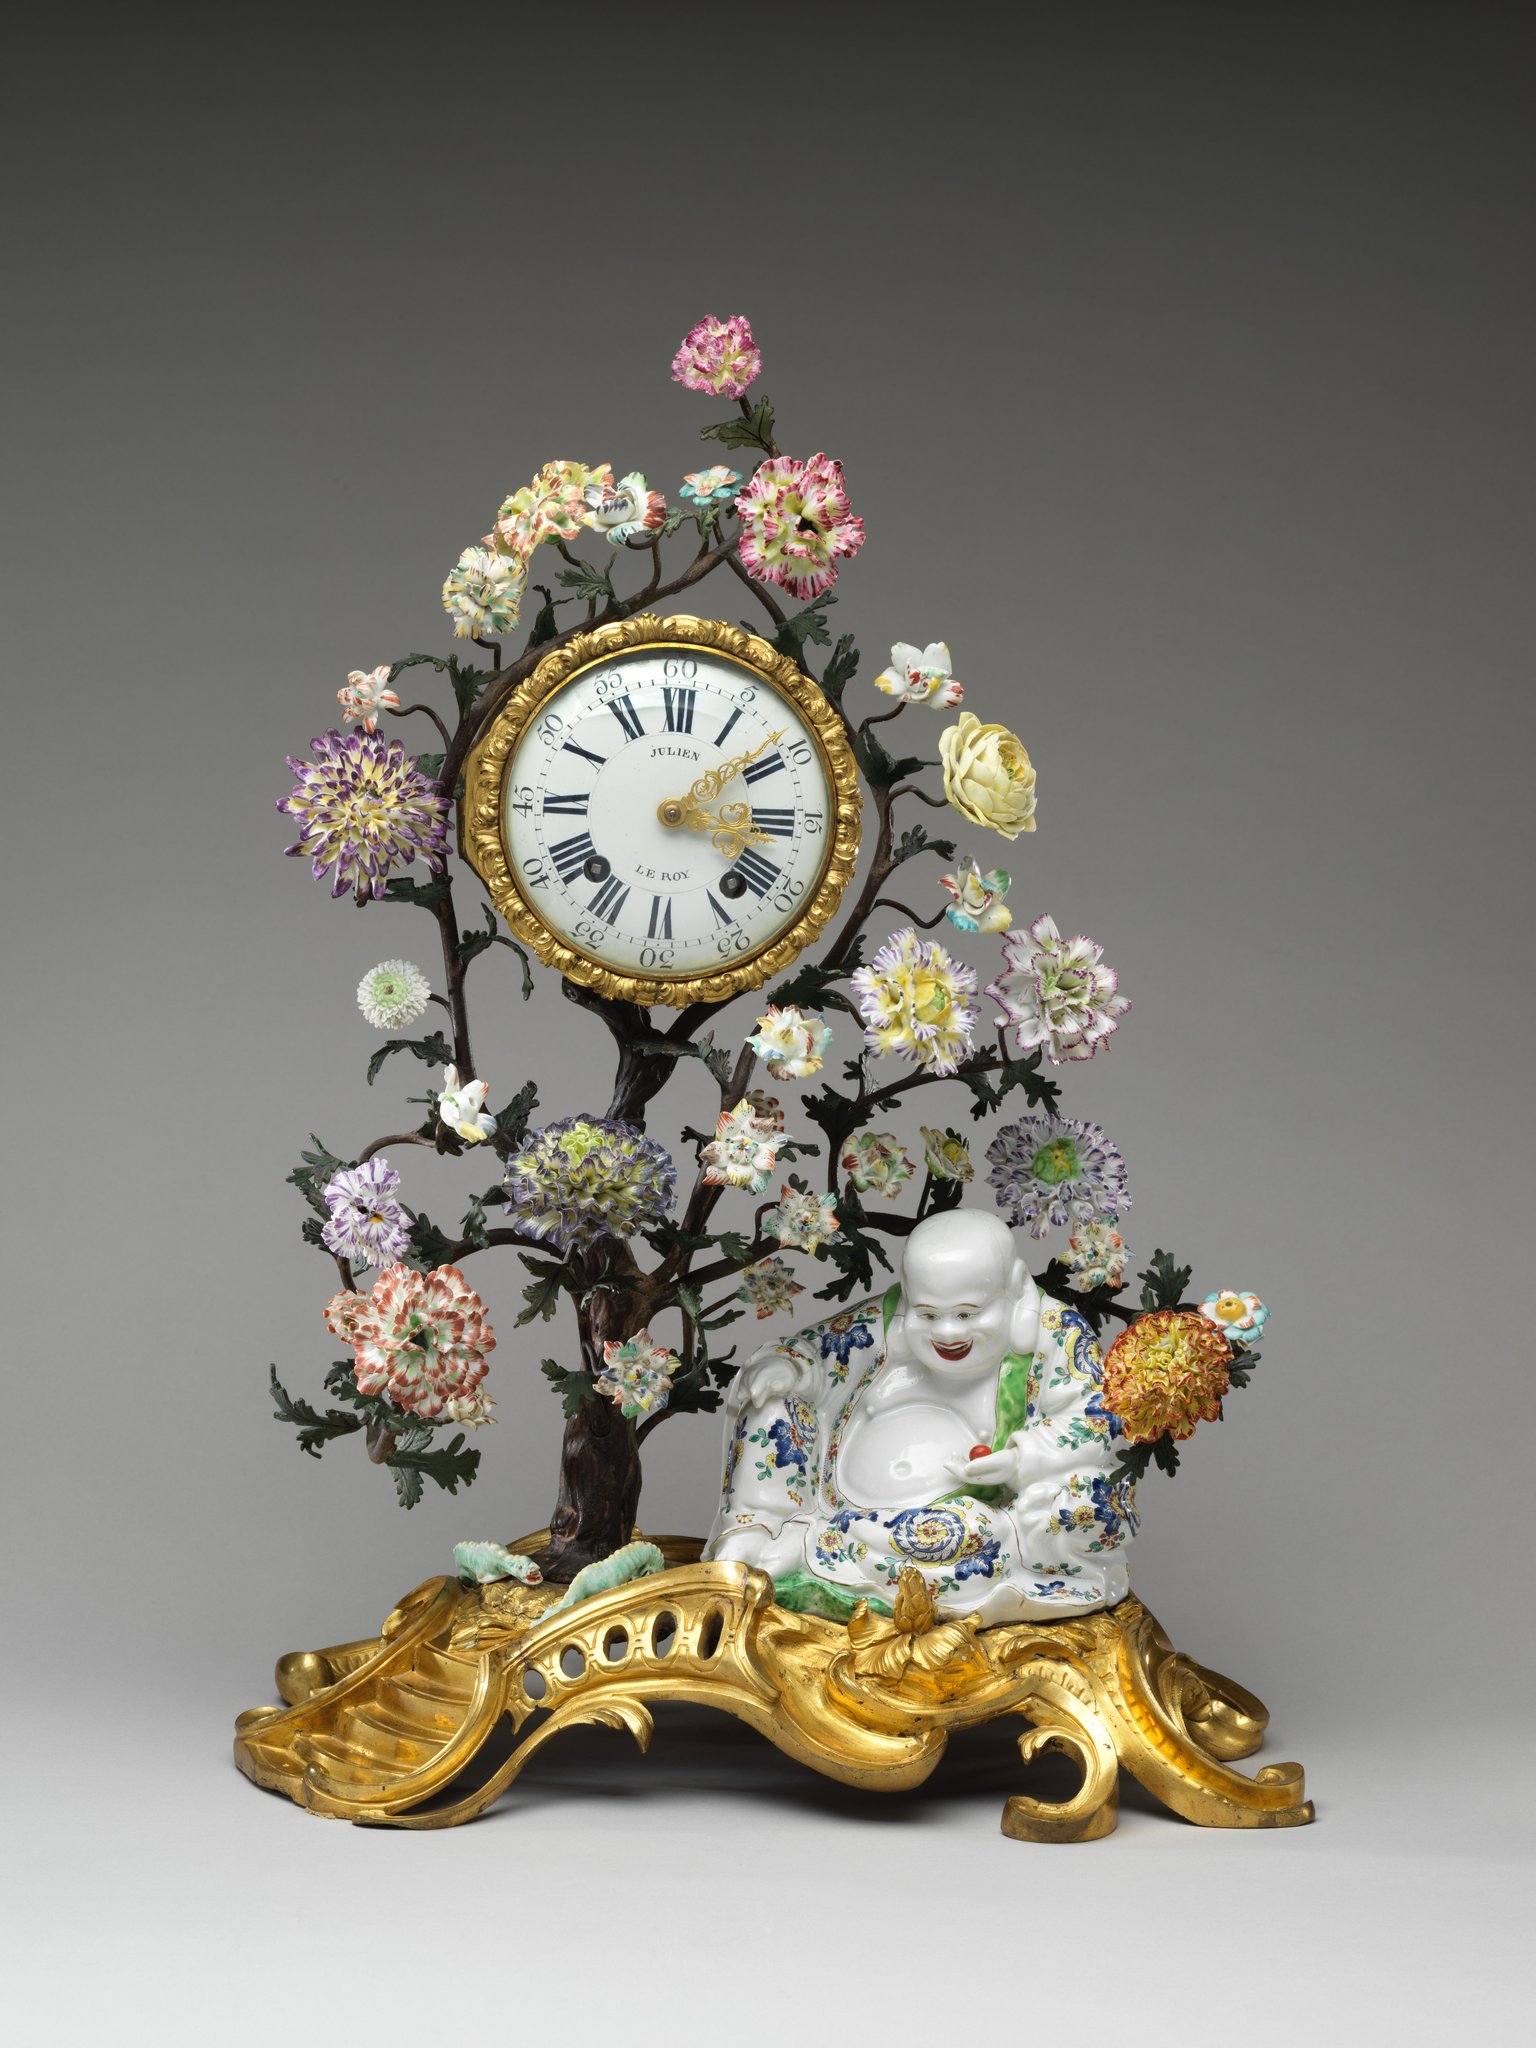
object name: mantel clock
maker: julien le roy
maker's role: maker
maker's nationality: french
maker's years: 1686-1759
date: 1745-1749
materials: gilt bronze, hard paste porcelain, metal, soft paste porcelain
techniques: enamel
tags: men,flowers